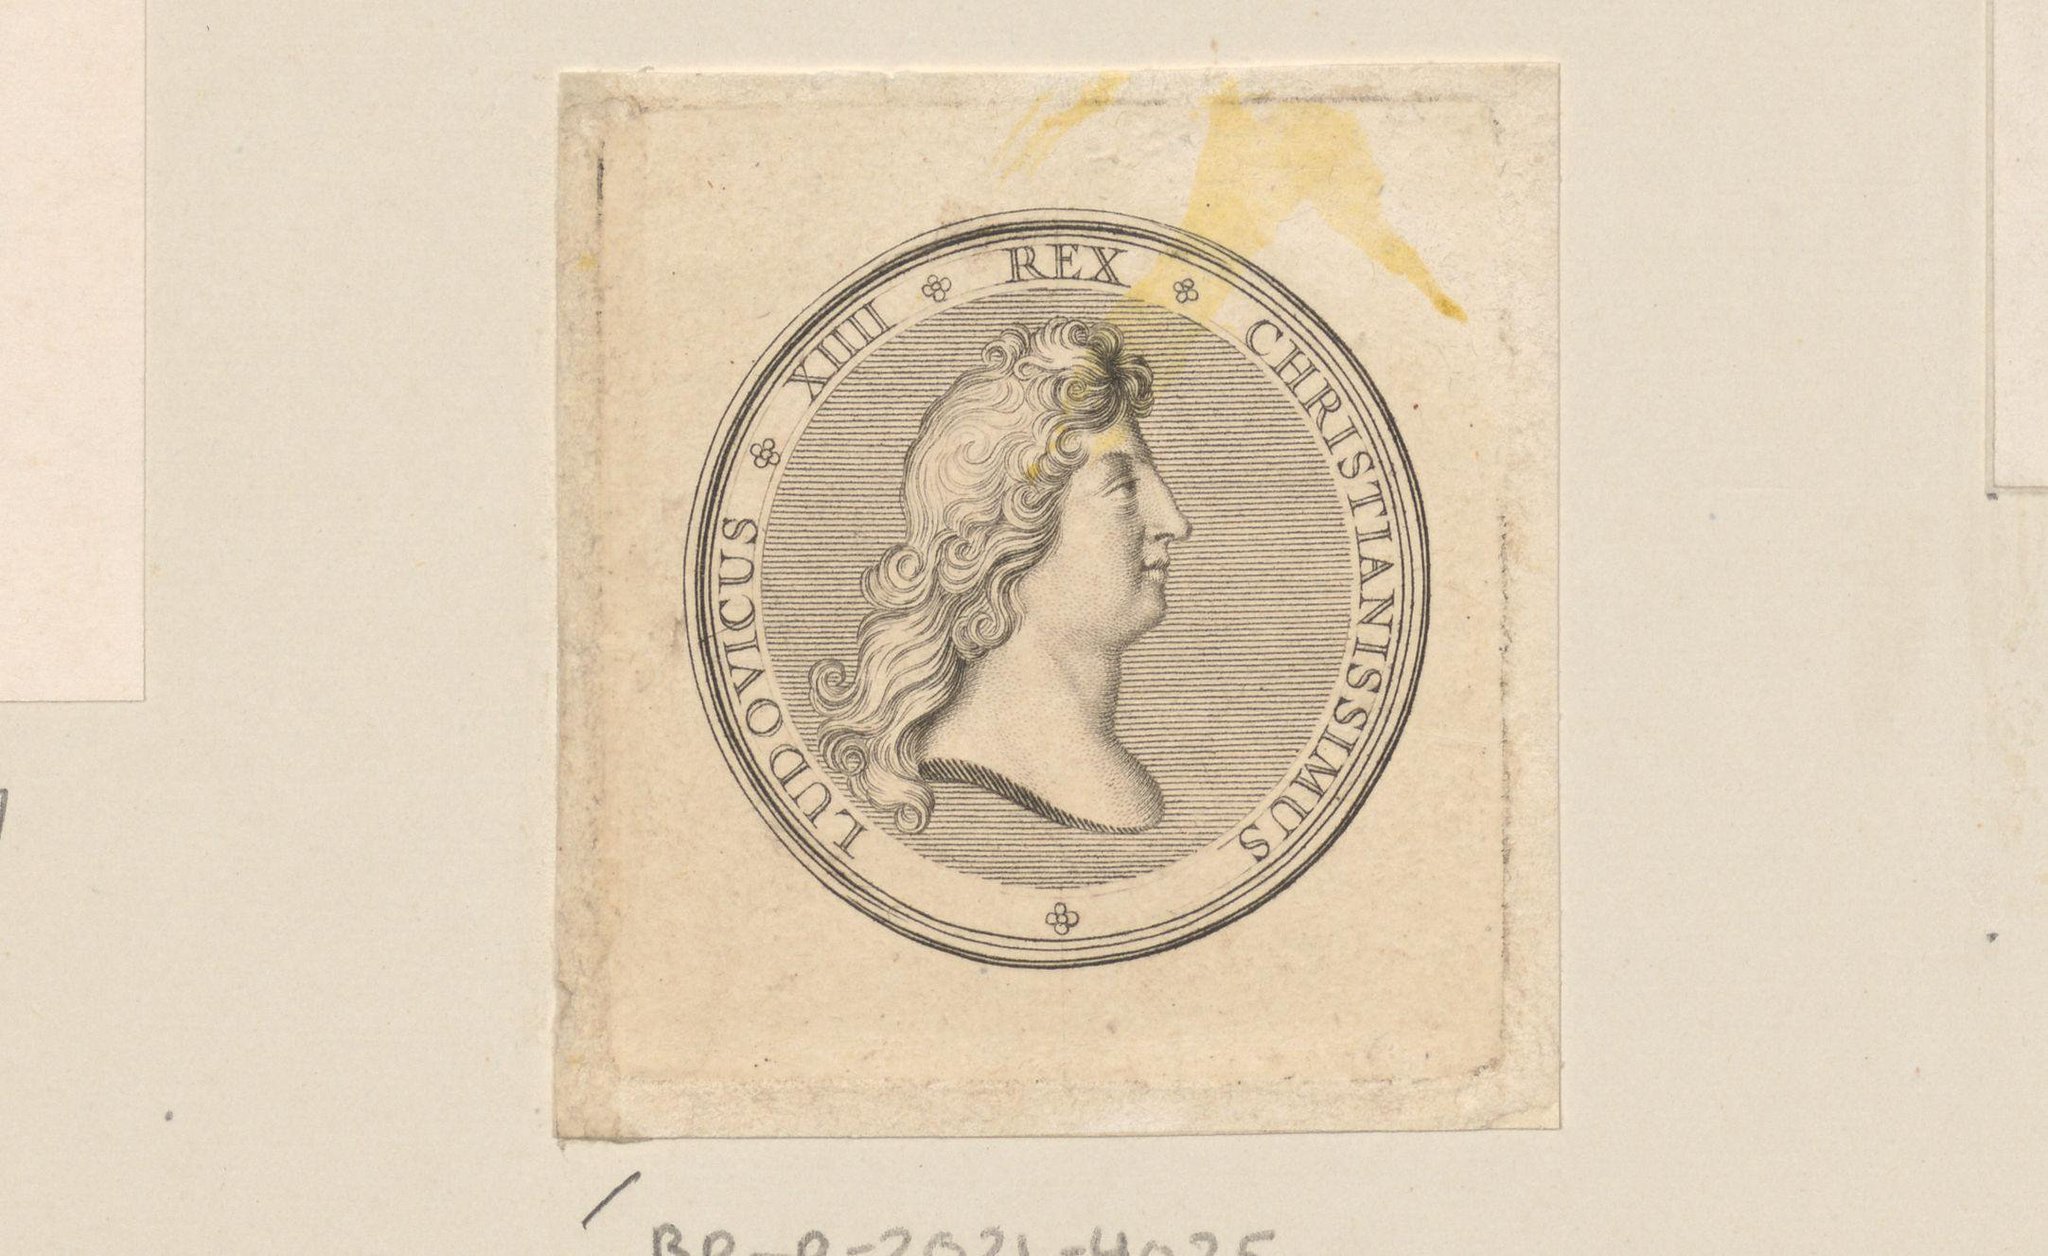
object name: print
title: Penning met buste van Lodewijk XIV van Frankrijk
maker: Anonymous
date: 1702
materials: paper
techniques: etching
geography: paris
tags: lodewijk xiv (koning van frankrijk), historical persons, medal (considered as a piece of sculpture, regardless of its specific function), king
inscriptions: collector's mark: Lugt 2228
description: Prent waarschijnlijk uit: Medailles sur les principaux evenements de regne de Louis le Grand (...). Parijs: L'Imprimerie Royale, 1702, p. 87.